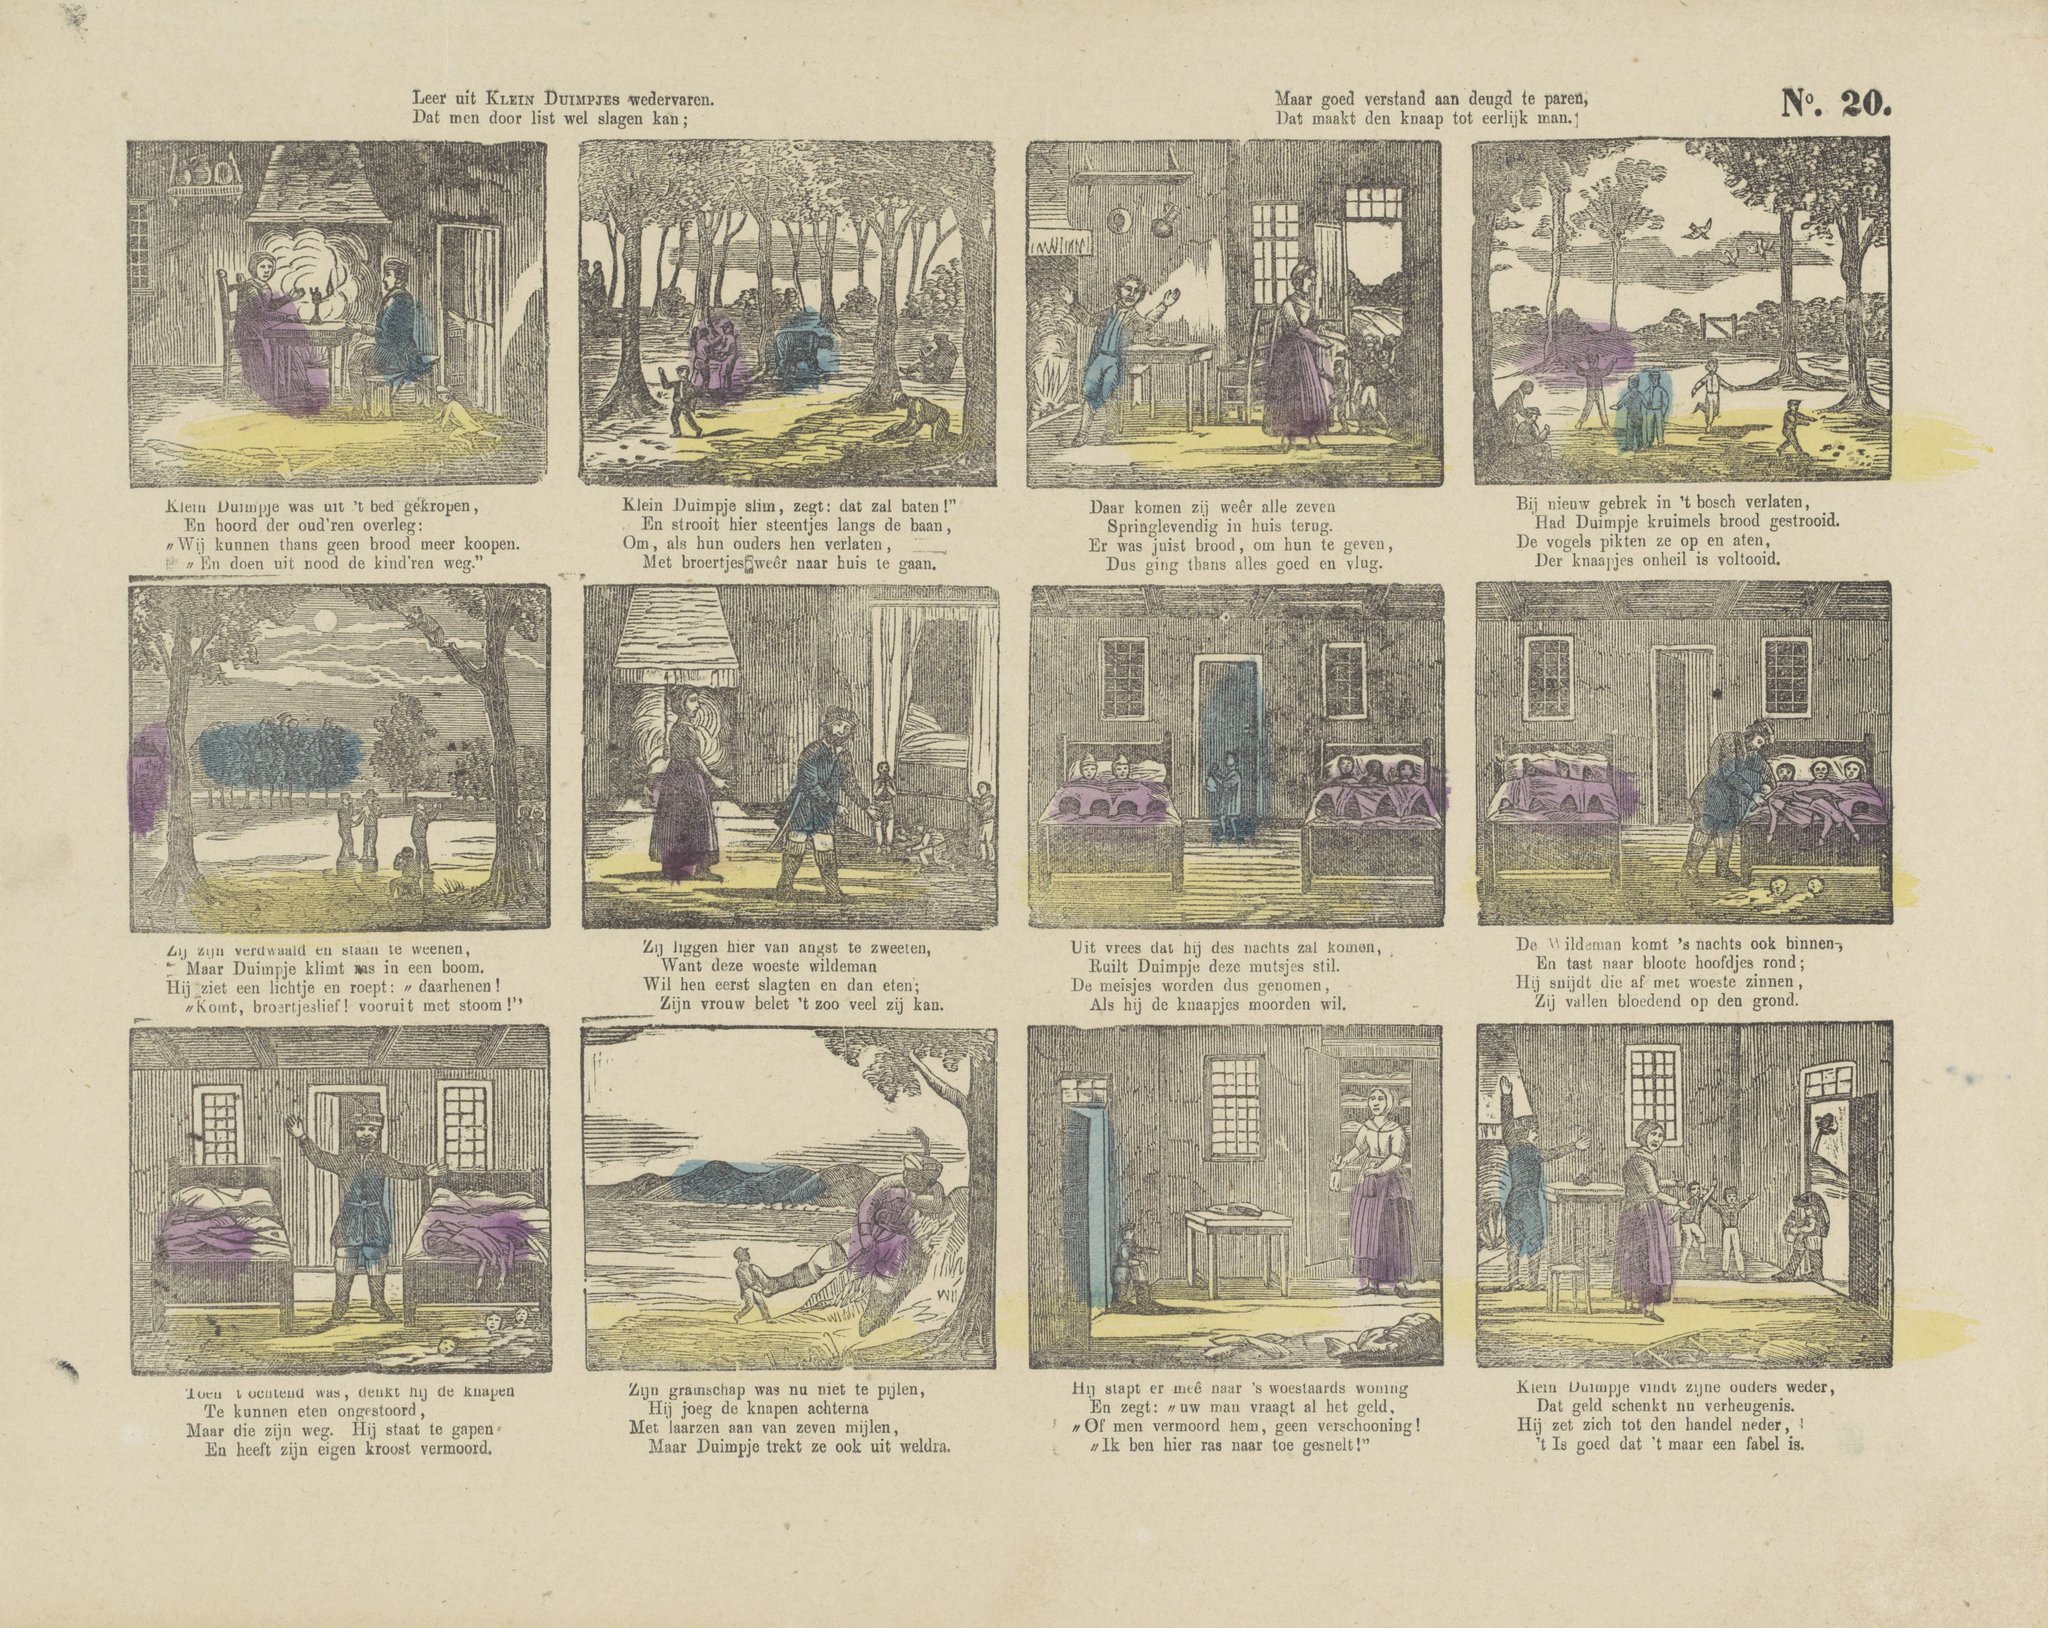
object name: popular print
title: Leer uit Klein Duimpjes wedervaren. / Dat men door list wel slagen kan; / Maar goed verstand aan deugd te paren, / Dat maakt den knaap tot eerlijk man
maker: Anonymous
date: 1850-1870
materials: paper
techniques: colour, letterpress printing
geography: netherlands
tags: tales and fairy tales: little thumbling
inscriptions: collector's mark: Lugt 2760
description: Blad met 12 voorstellingen uit het sprookje van Klein Duimpje. Onder elke voorstelling een vierregelig vers. Rechtsboven genummerd: No. 20.